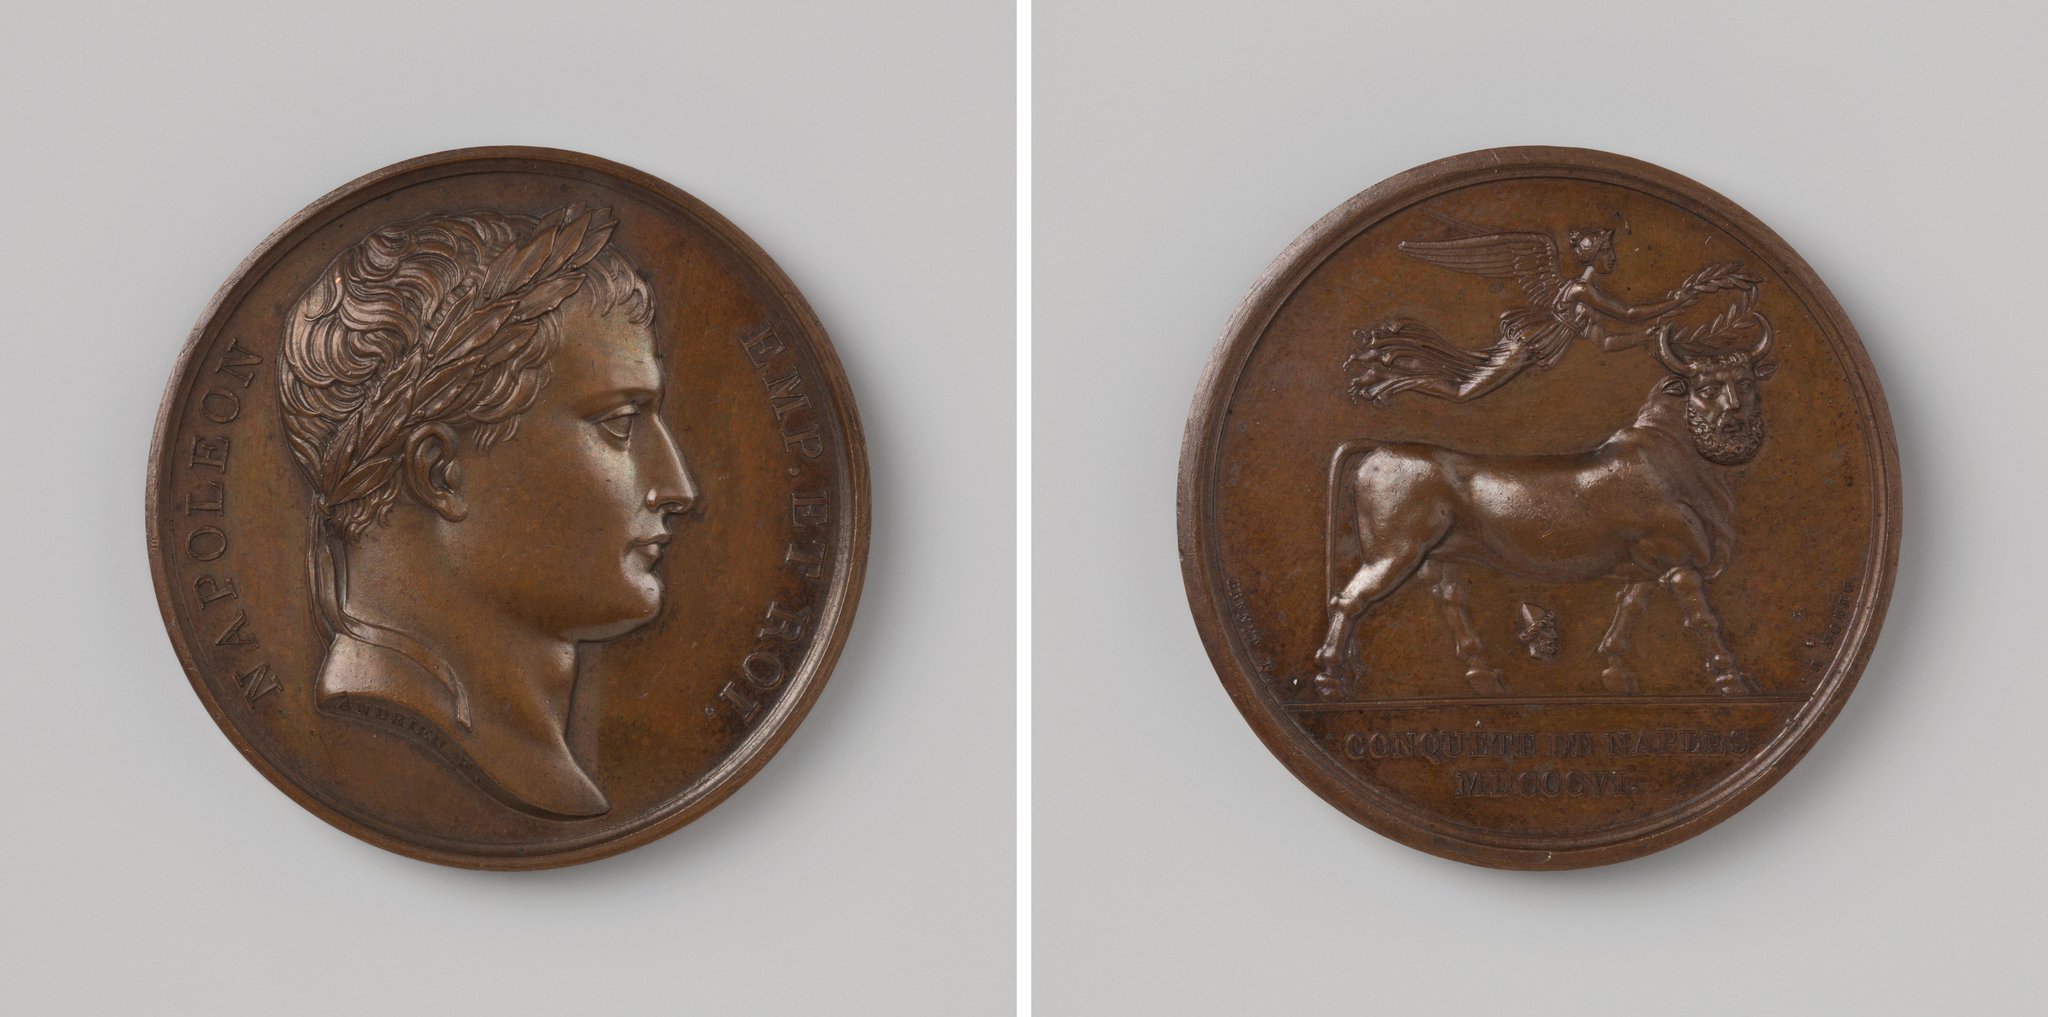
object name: history medal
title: Verovering van Napels, ter ere van Napoleon I Bonaparte, keizer der Fransen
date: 1806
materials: bronze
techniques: striking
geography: paris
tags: napoleon i (emperor of the french), naples